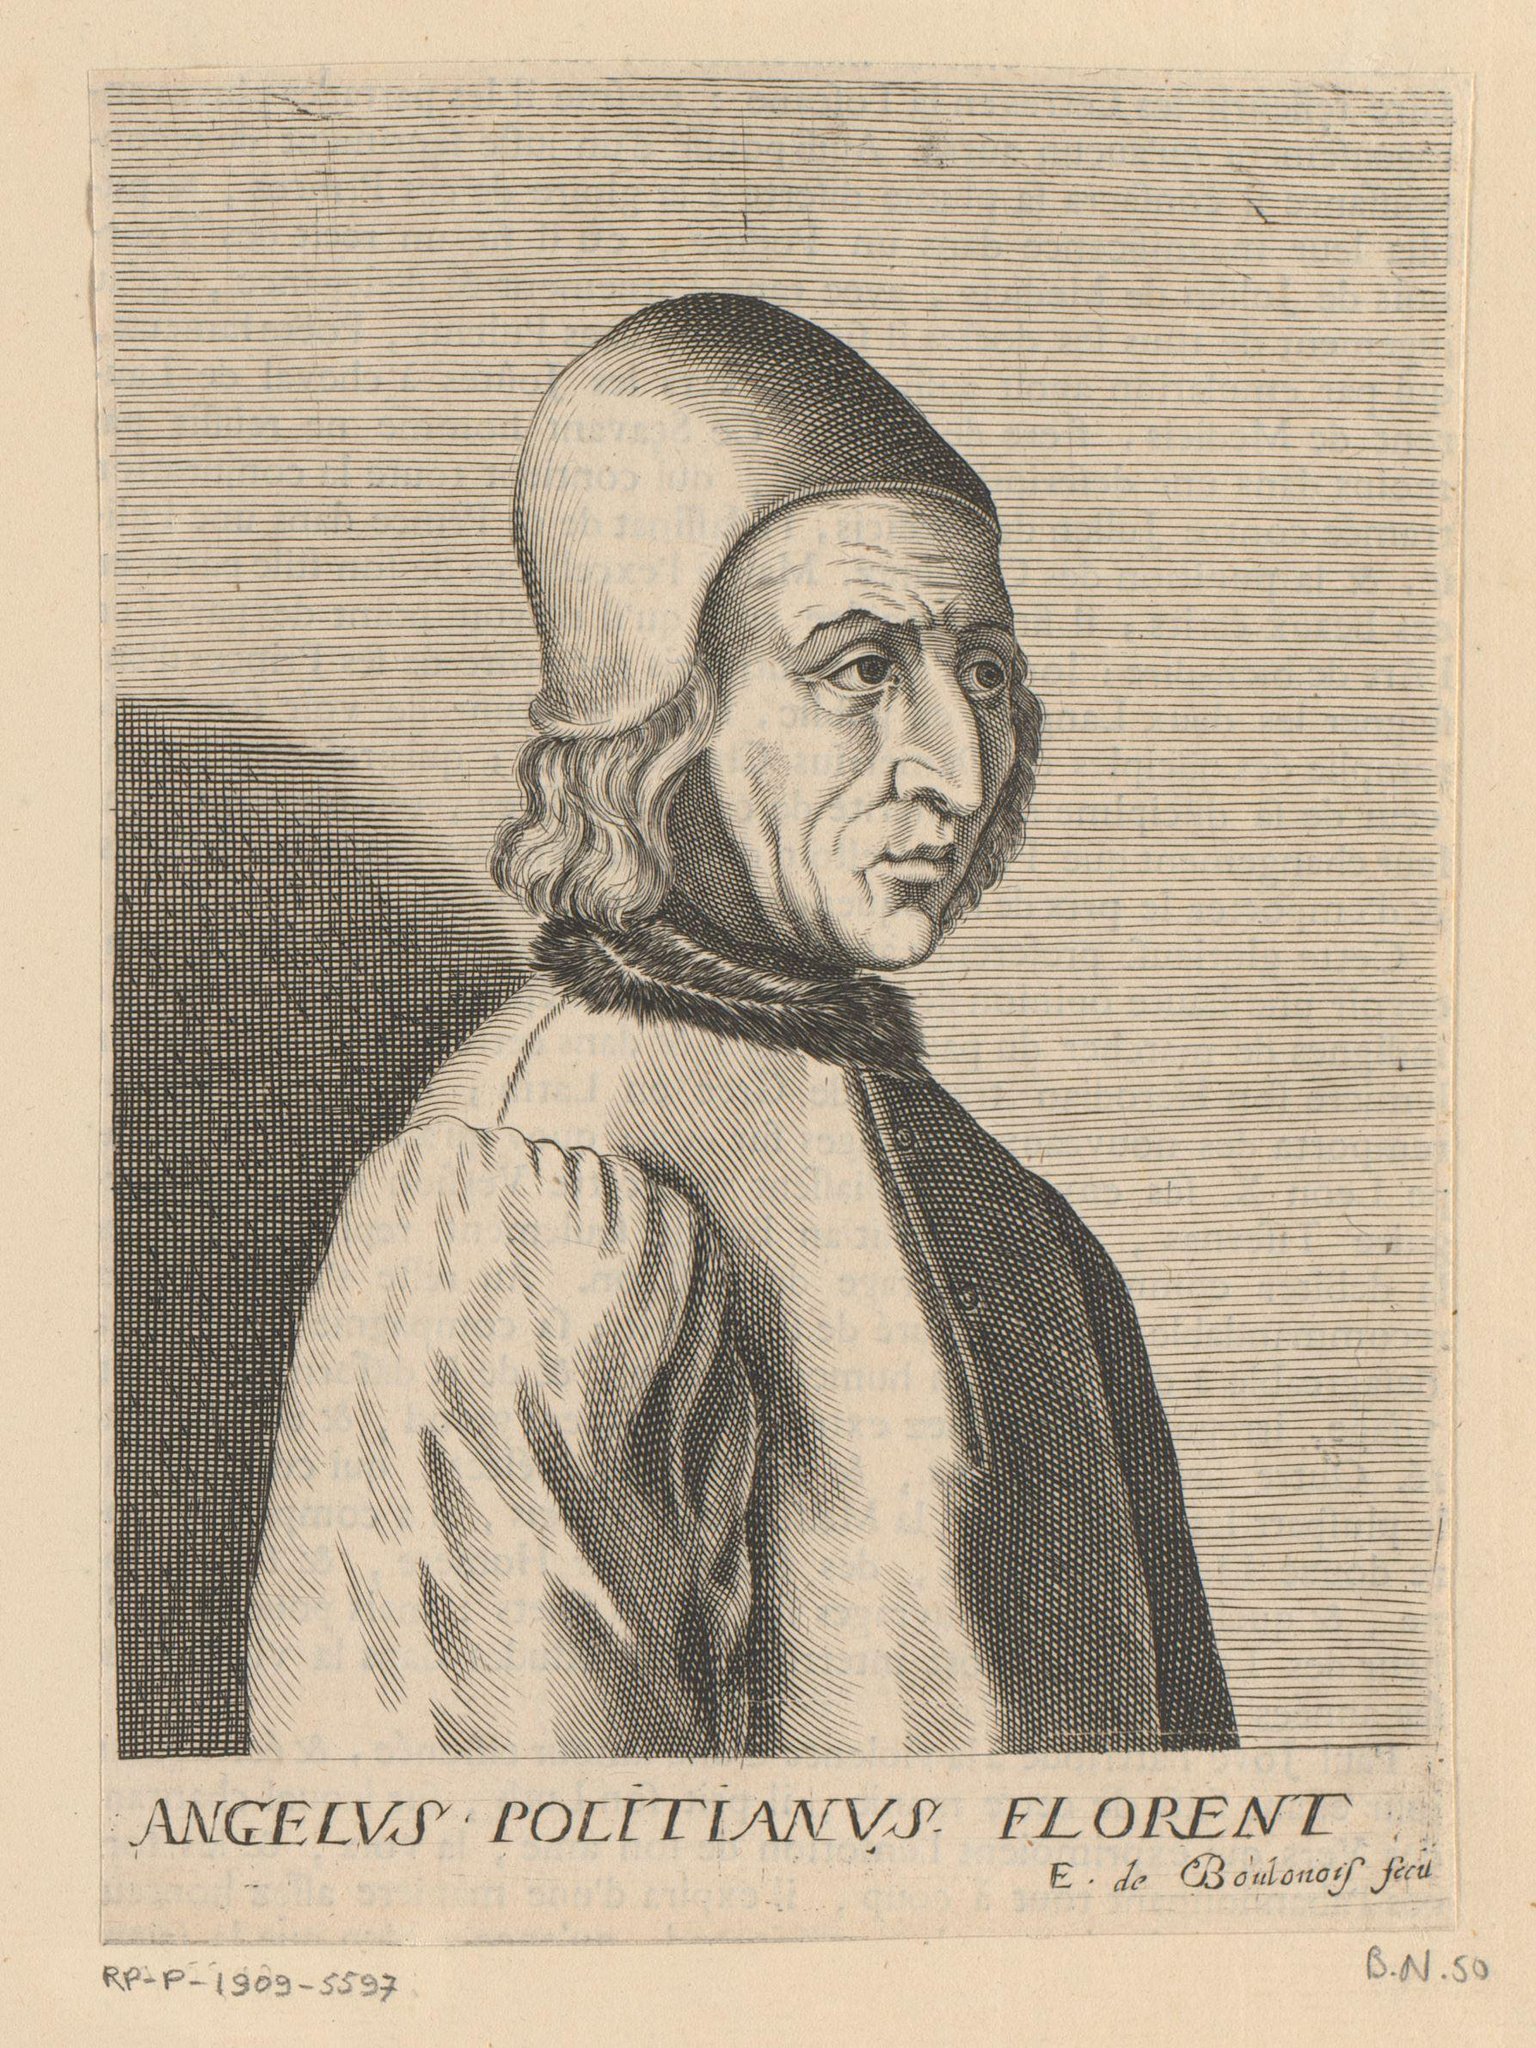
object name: print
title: Angelus Politianus Florent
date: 1682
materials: paper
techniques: engraving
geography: brussels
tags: historical persons, portrait of a writer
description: Prent uit: Bullert, Isaac. Académie des Sciences et Arts contenant les vies et éloges his. des hommes illustres qui ont excellé en ces professions depuis environ quatre siècles. Brussel: Foppens, François, 1682. Het boek werd in 1682 eveneens in Amsterdam uitgegeven door de erfgenamen van Daniel Elzevier. Deze portretten dienen ter illustratie van de biografie van een kunstenaar of geleerde. De meeste portretten werden door Nicolas de Larmessin vervaardigd (162), 93 door De Boulonois en een derde door ongeïdentificeerde prentmakers. Dit betreft een illustratie op p. 277, deel I.